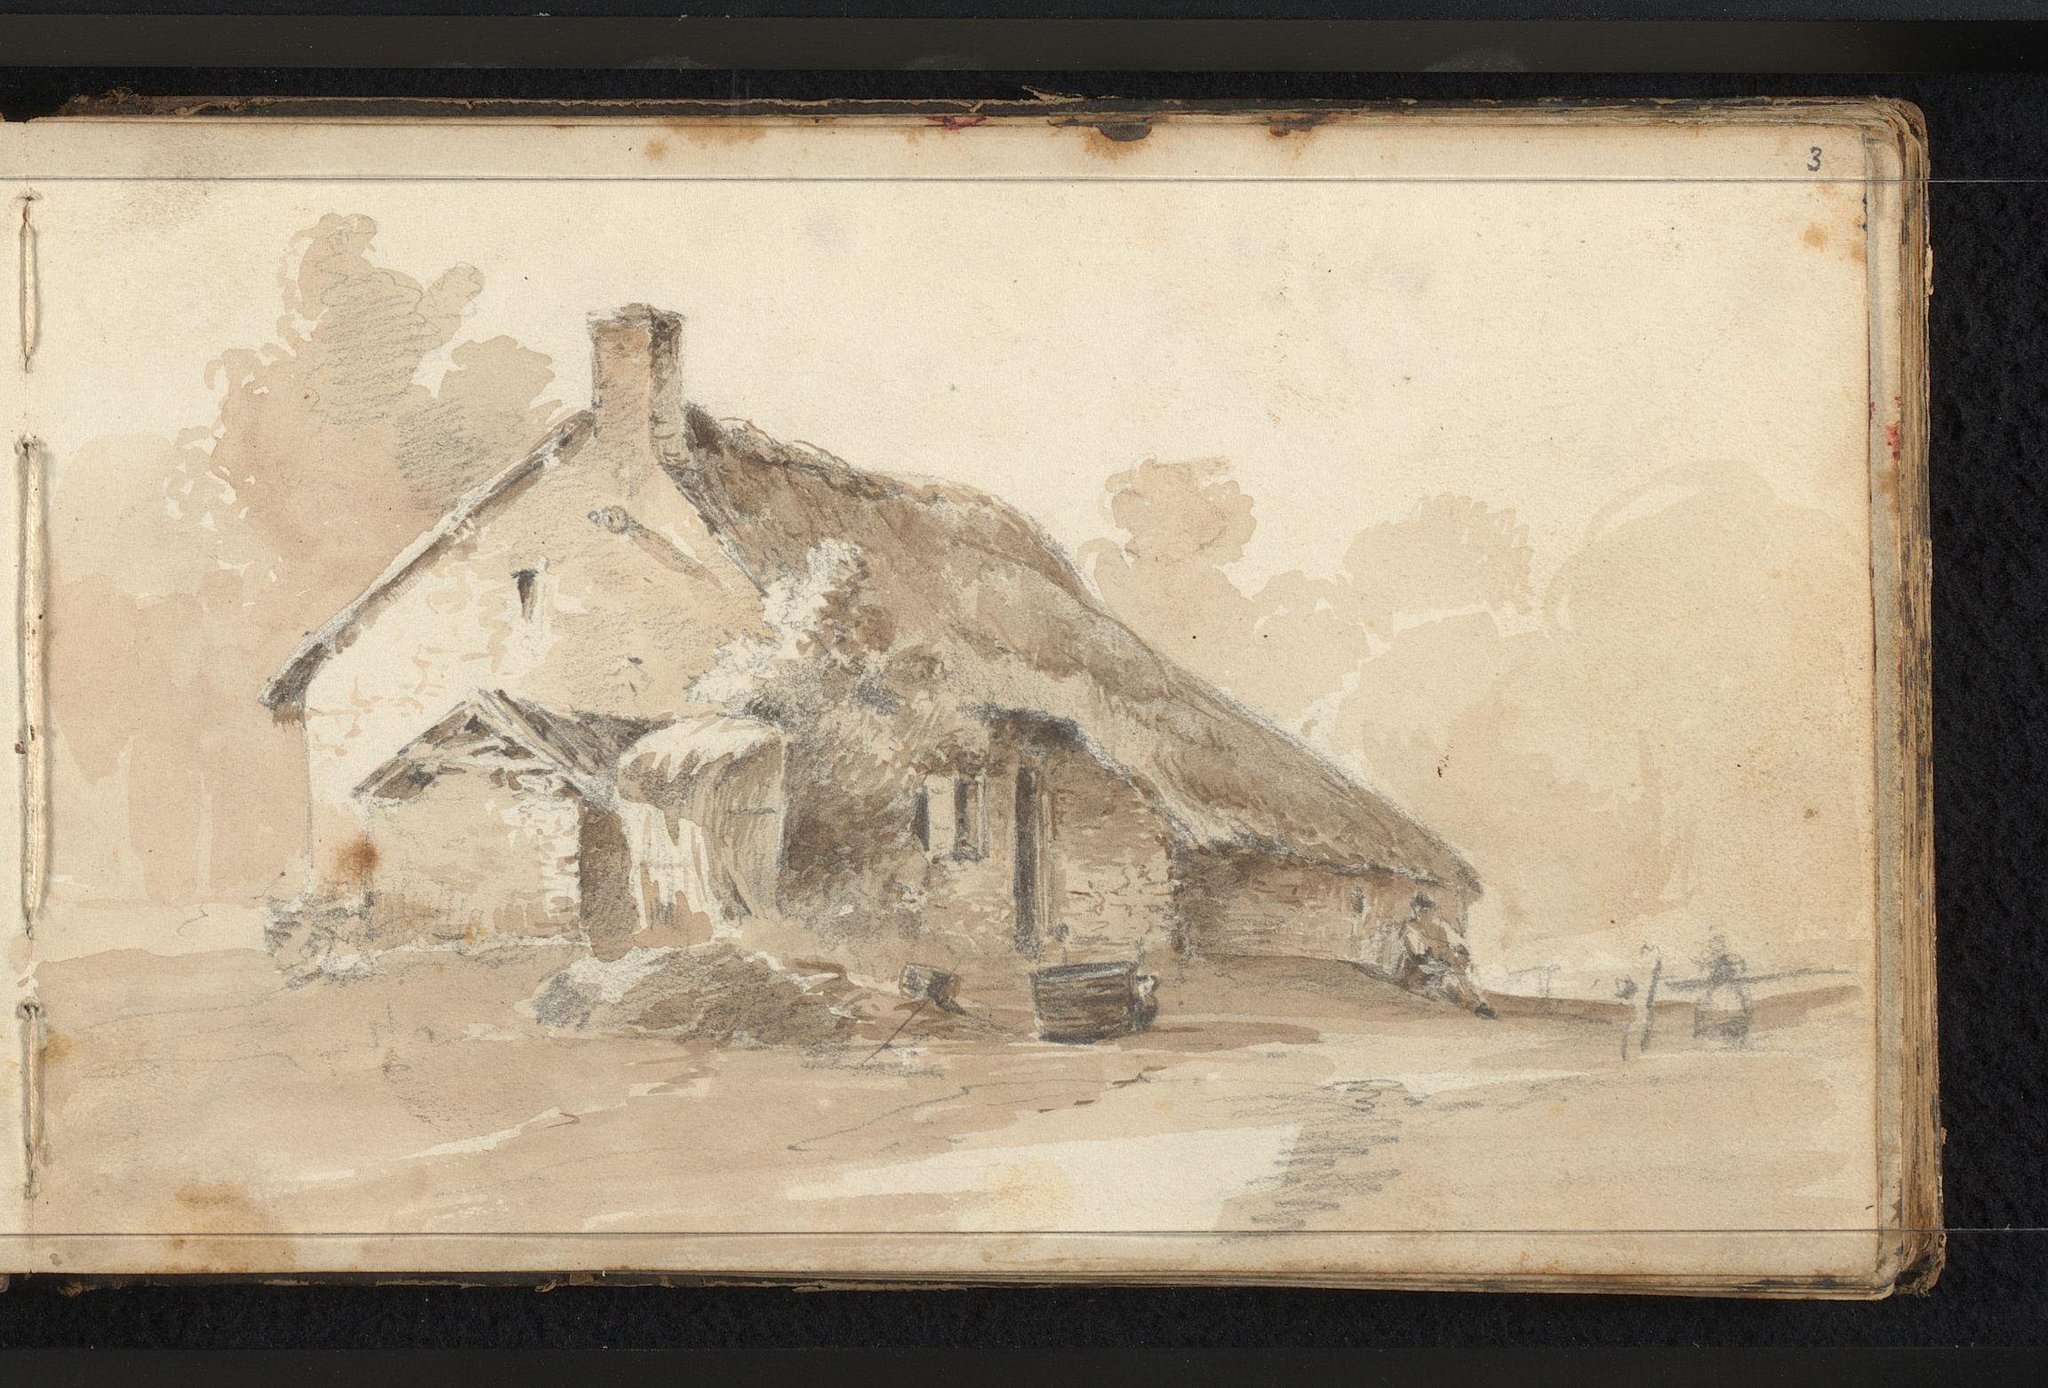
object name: sketchbook leaf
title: Boerderij met rieten dak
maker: jan bedijs tom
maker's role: draughtsman, painter, print maker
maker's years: 1813-1894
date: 1828-1894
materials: paper, pencil, watercolor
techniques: brush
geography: the hague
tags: trees, landscapes, artist (in general) making preliminary designs, sketching, farm or solitary house in landscape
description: Pagina 3 recto uit een schetsboek met 54 bladen.